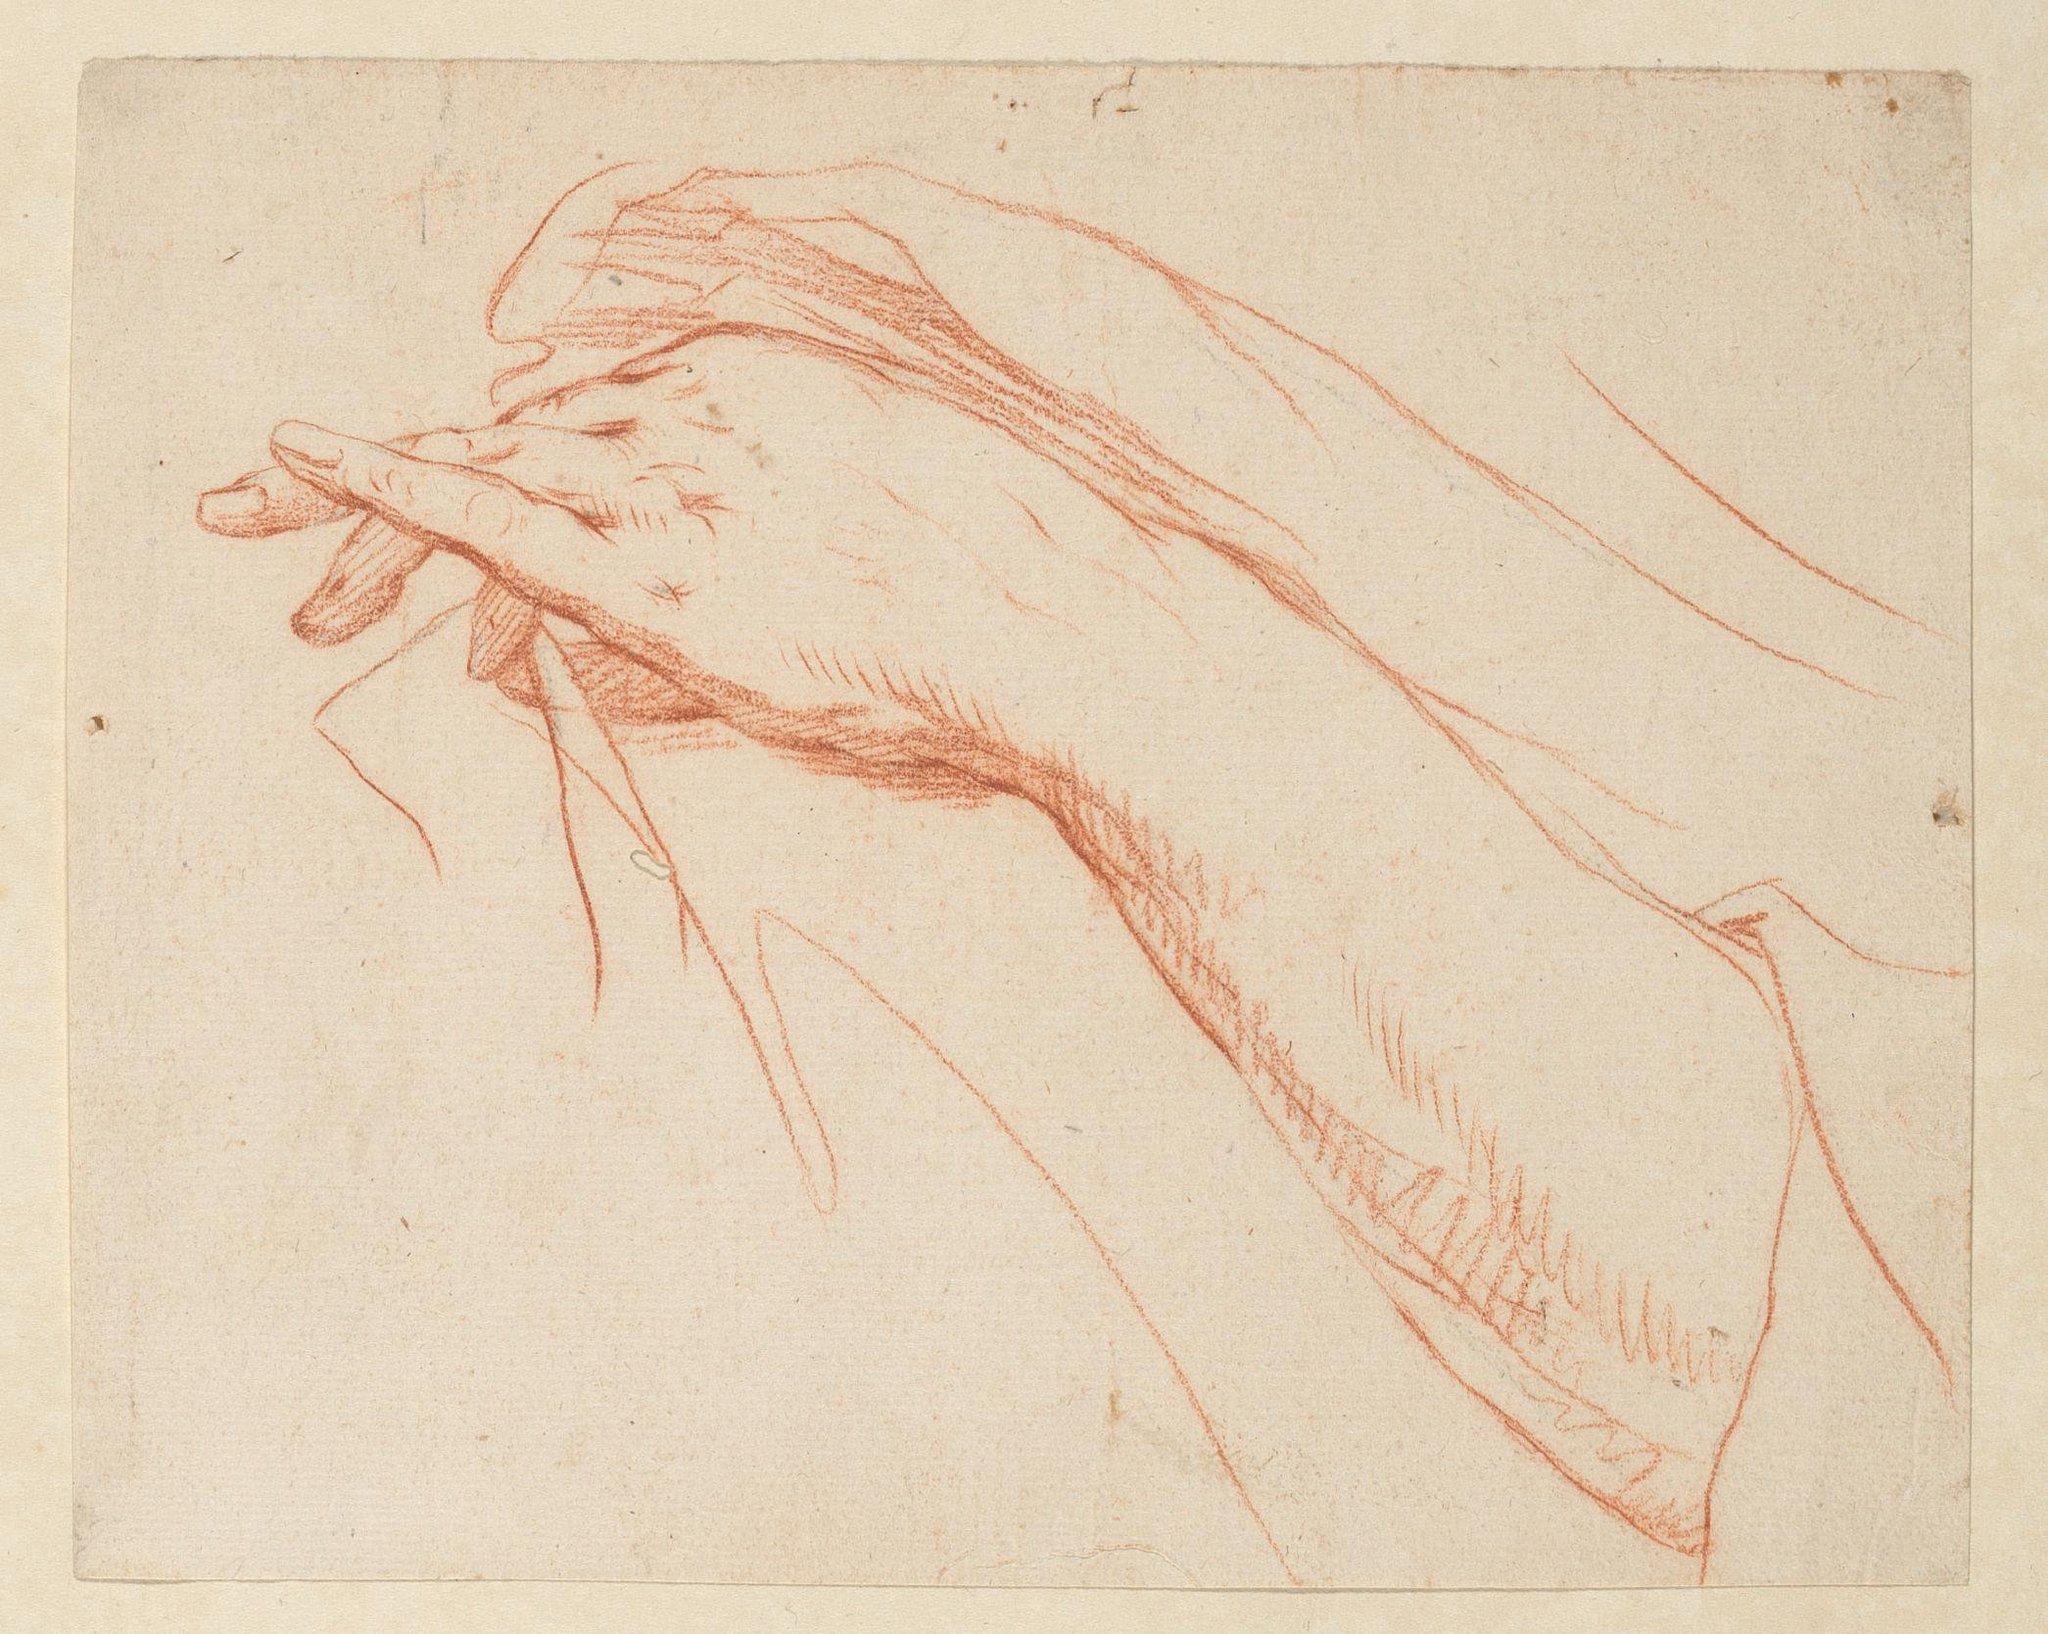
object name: drawing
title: Studie van een hand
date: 1649-1723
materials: chalk, paper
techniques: pasting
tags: postures and gestures of hand and fingers